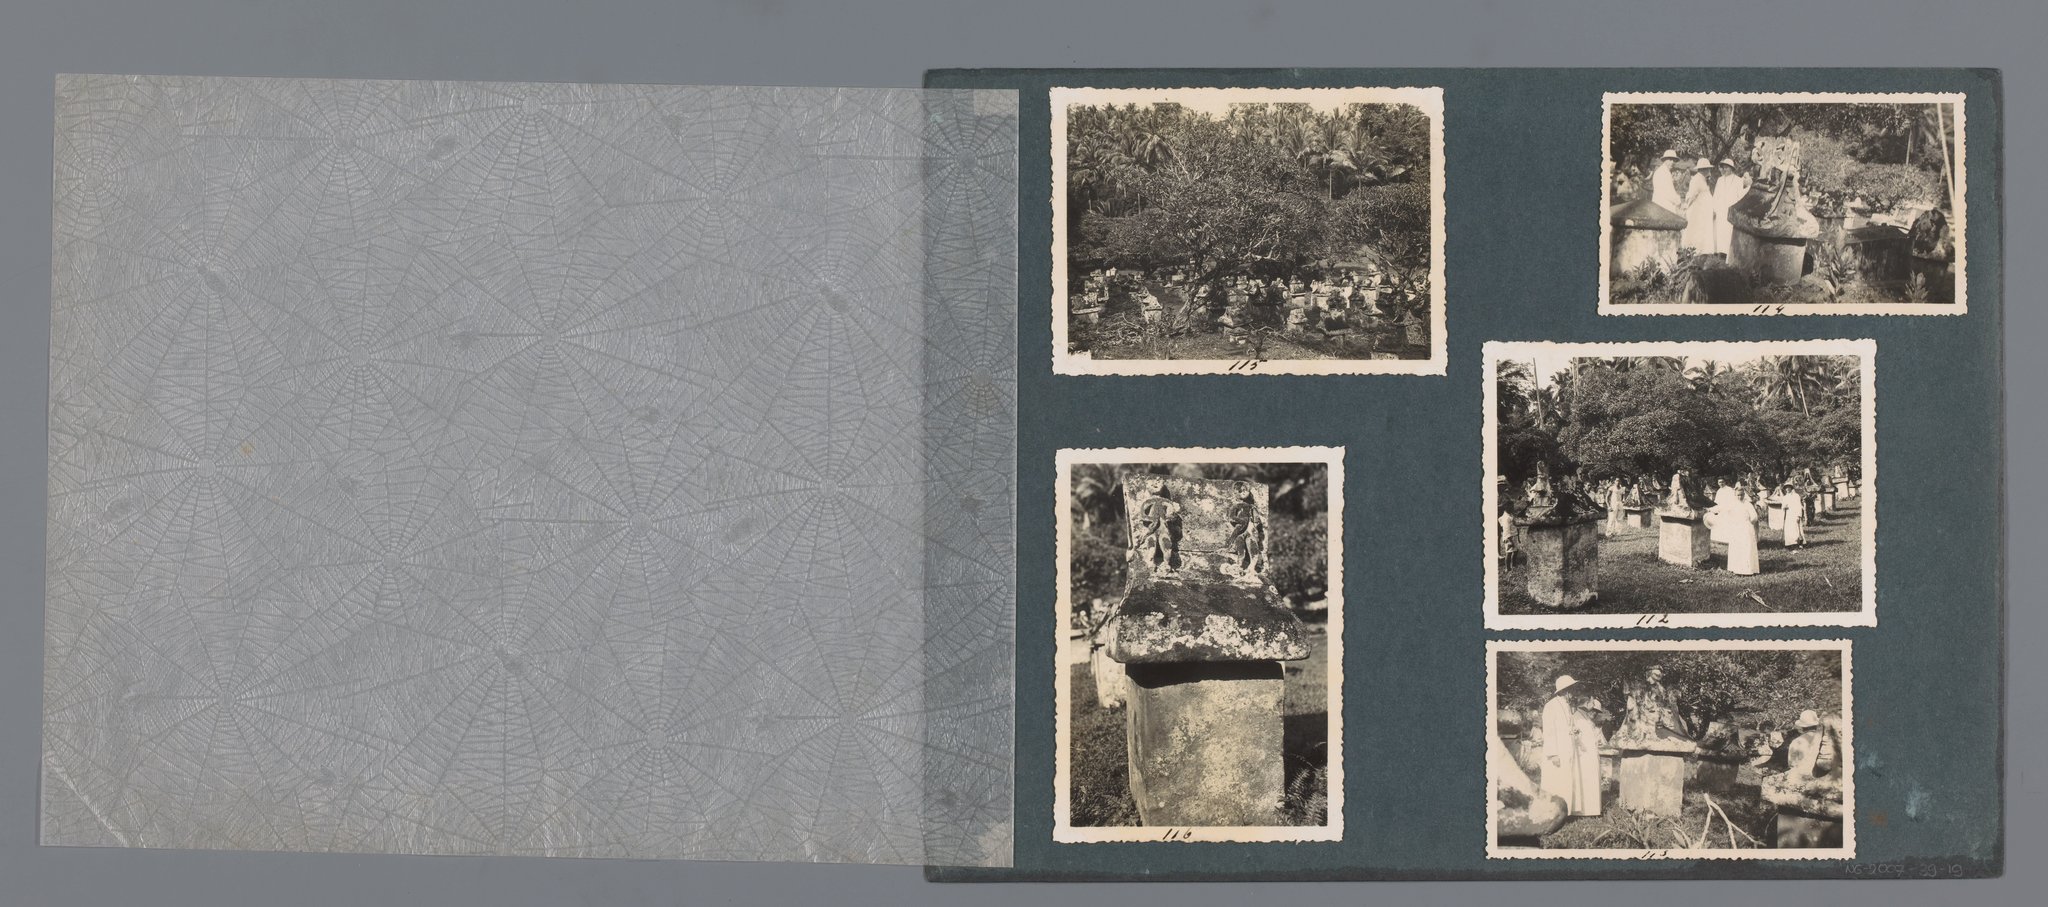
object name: photograph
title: Waruga graven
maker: Anonymous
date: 1930-1939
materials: paper, photographic support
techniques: gelatin silver print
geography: celebes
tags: gravestone, tombstone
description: Zwart albumblad met vijf foto's van waruga (grafstenen) en de fraters op bezoek op de begraafplaats van Minahasa op Noord-Sulawesi. De foto's zijn genummerd 112-116. Onderdeel van het losbladig fotoalbum over de Fraters van Tilburg op Celebes en Sumatra.